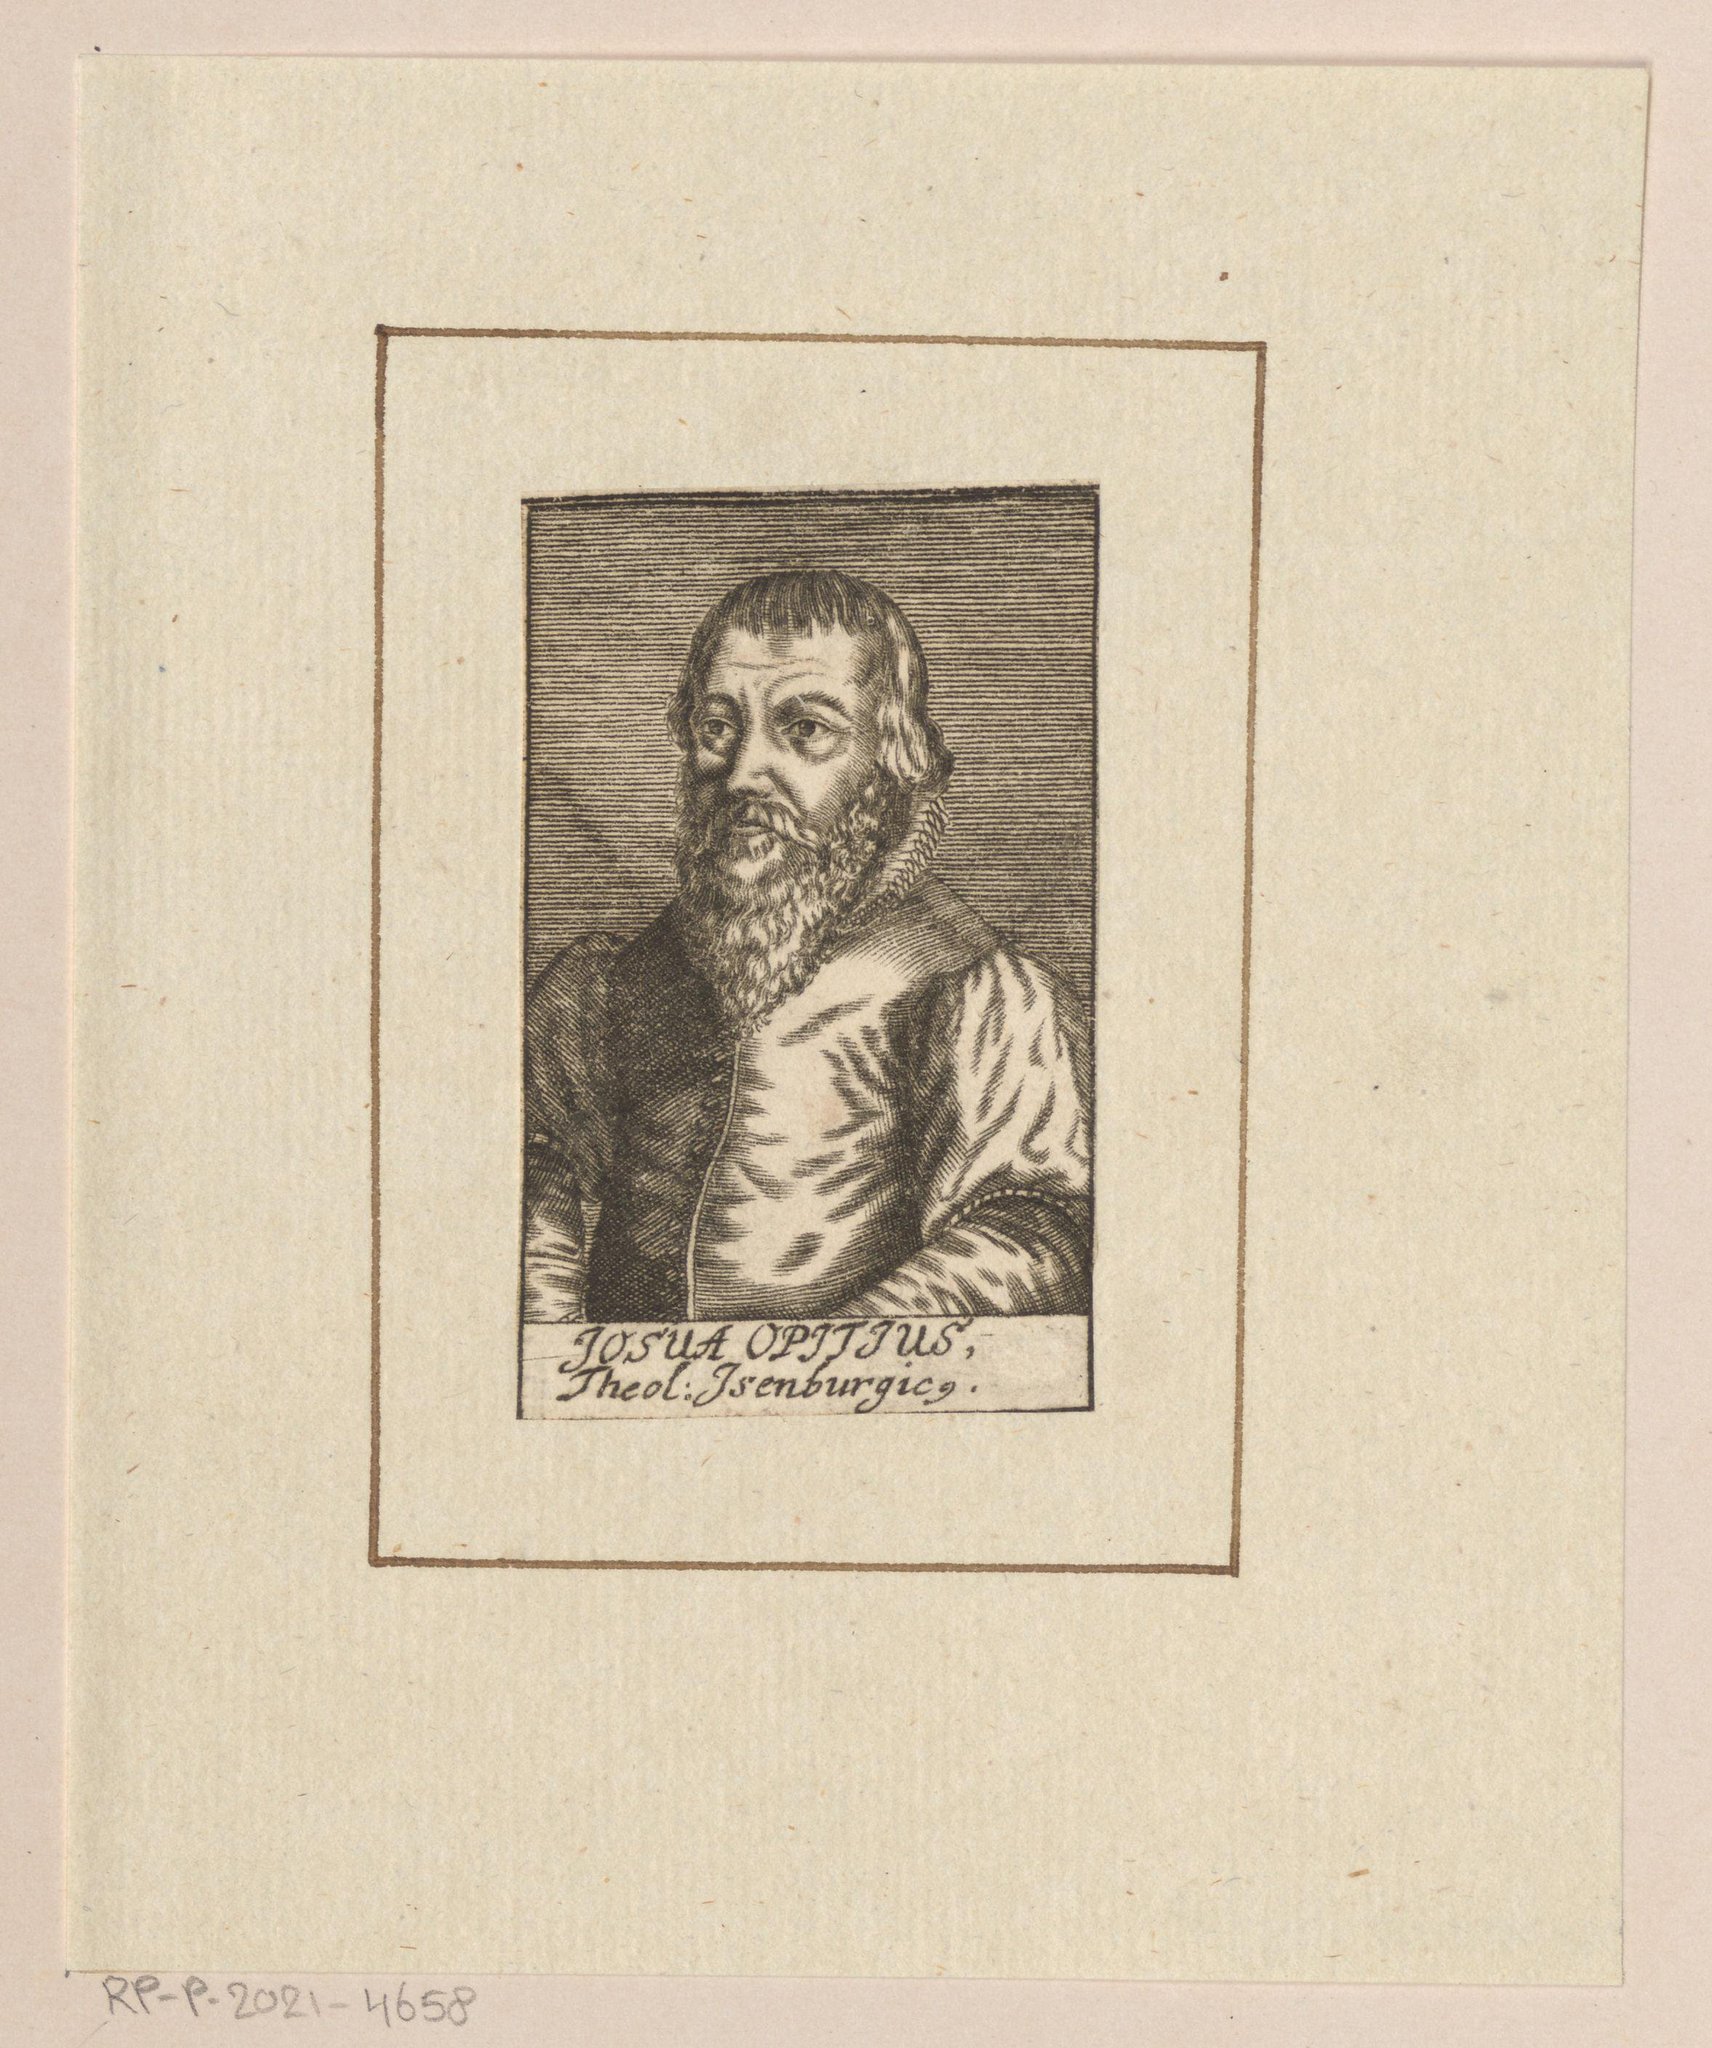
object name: print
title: Portret van Johannes Oporinus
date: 1688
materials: paper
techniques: engraving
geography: nuremberg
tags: printer, historical persons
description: Prent mogelijk uit: Freher, Paul. Theatrum virorum eruditione clarorum. Neurenberg: Johann Hoffmann, 1688, dl. 1.